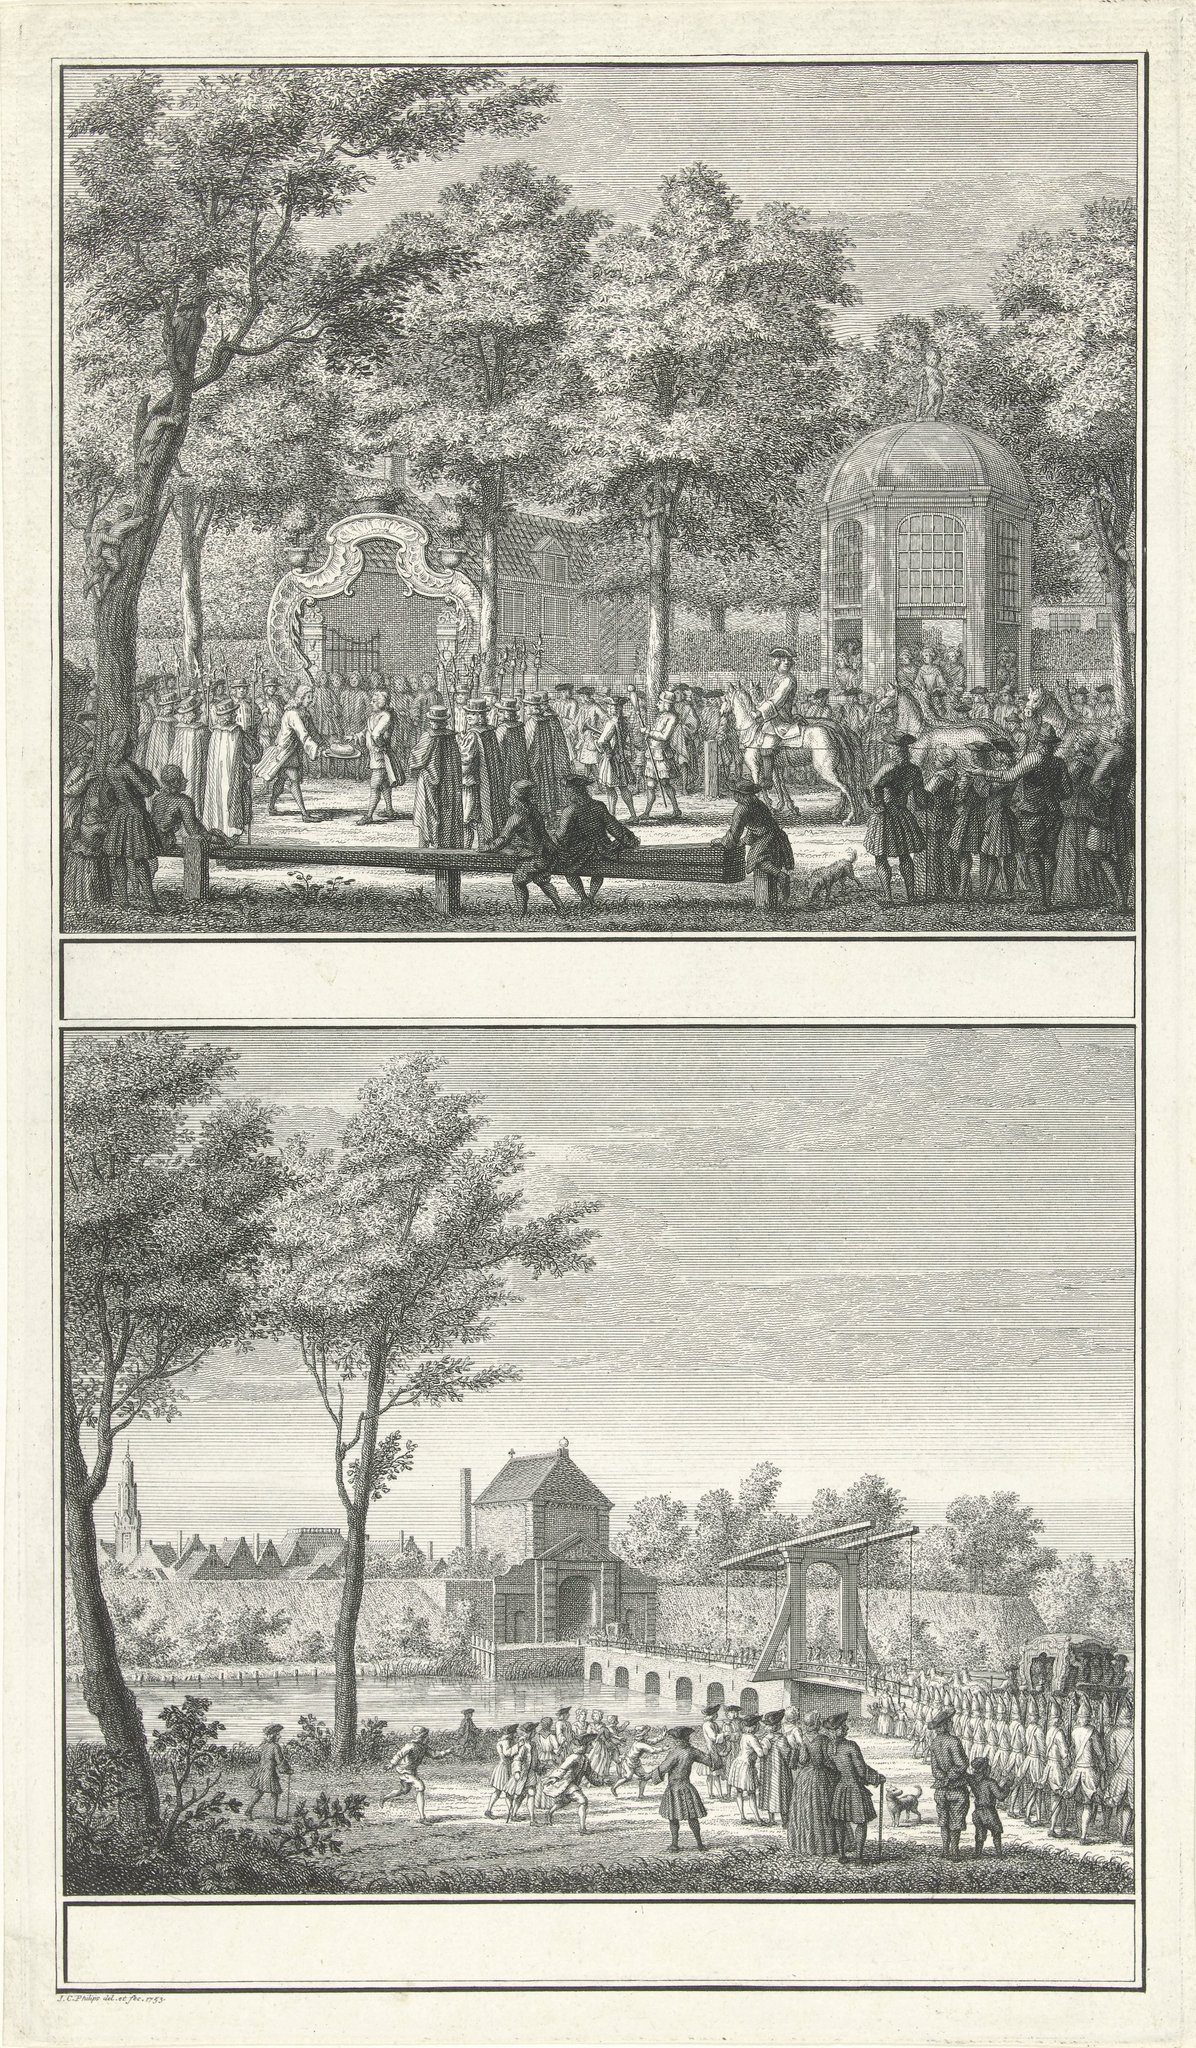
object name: print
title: Twee voorstellingen van de aankomst bij de stad en van het aanbieden van de sleutels aan Willem IV, 1751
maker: jan caspar philips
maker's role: draughtsman, print maker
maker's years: 1700-1775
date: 1753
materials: paper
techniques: engraving, etching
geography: northern netherlands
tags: the hague, willem iv (prins van oranje-nassau), triumphal entry and public reception, pageant, 'entrée solennelle', 'joyeuse entrée', surrender of keys, flushing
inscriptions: collector's mark: Lugt 2228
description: Blad met twee voorstellingen. Onderaan de aankomst van de stoet met het rijtuig van de stadhouder bij de Rammekens Poort. Bovenaan het aanbieden van de sleutels aan Willem IV door leden van de magistraat. Onderdeel van de illustraties van de inhuldiging van Willem IV als erfheer van Vlissingen op 5 juni 1751.